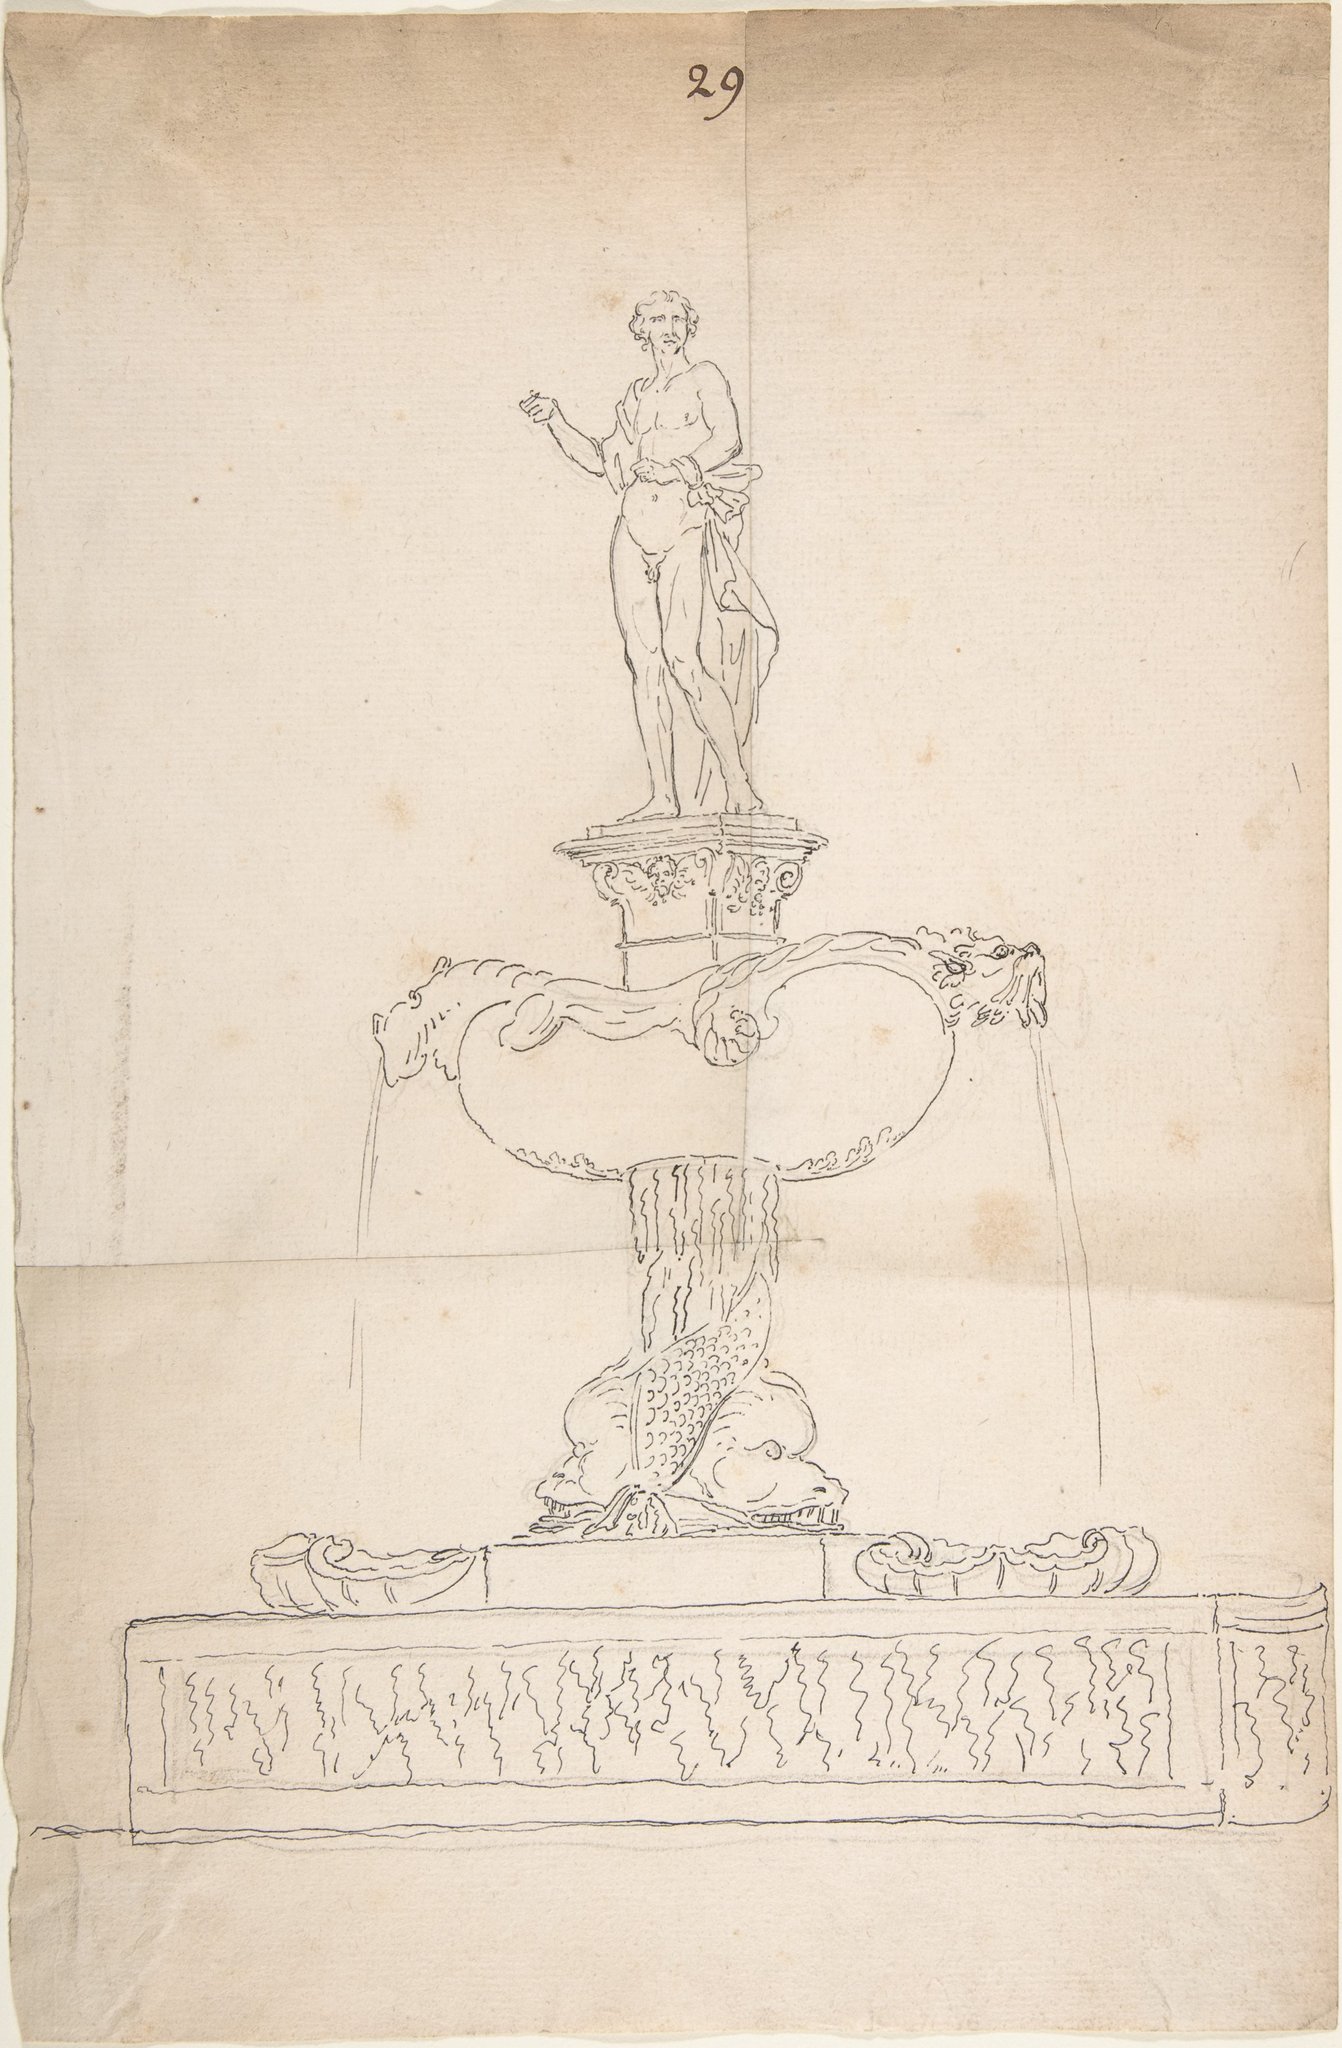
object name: drawing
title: Sketch of Fountain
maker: anonymous, french, 18th century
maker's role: artist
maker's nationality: french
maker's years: 1700-1800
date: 1701-1800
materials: graphite, ink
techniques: pen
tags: fountains,male nudes